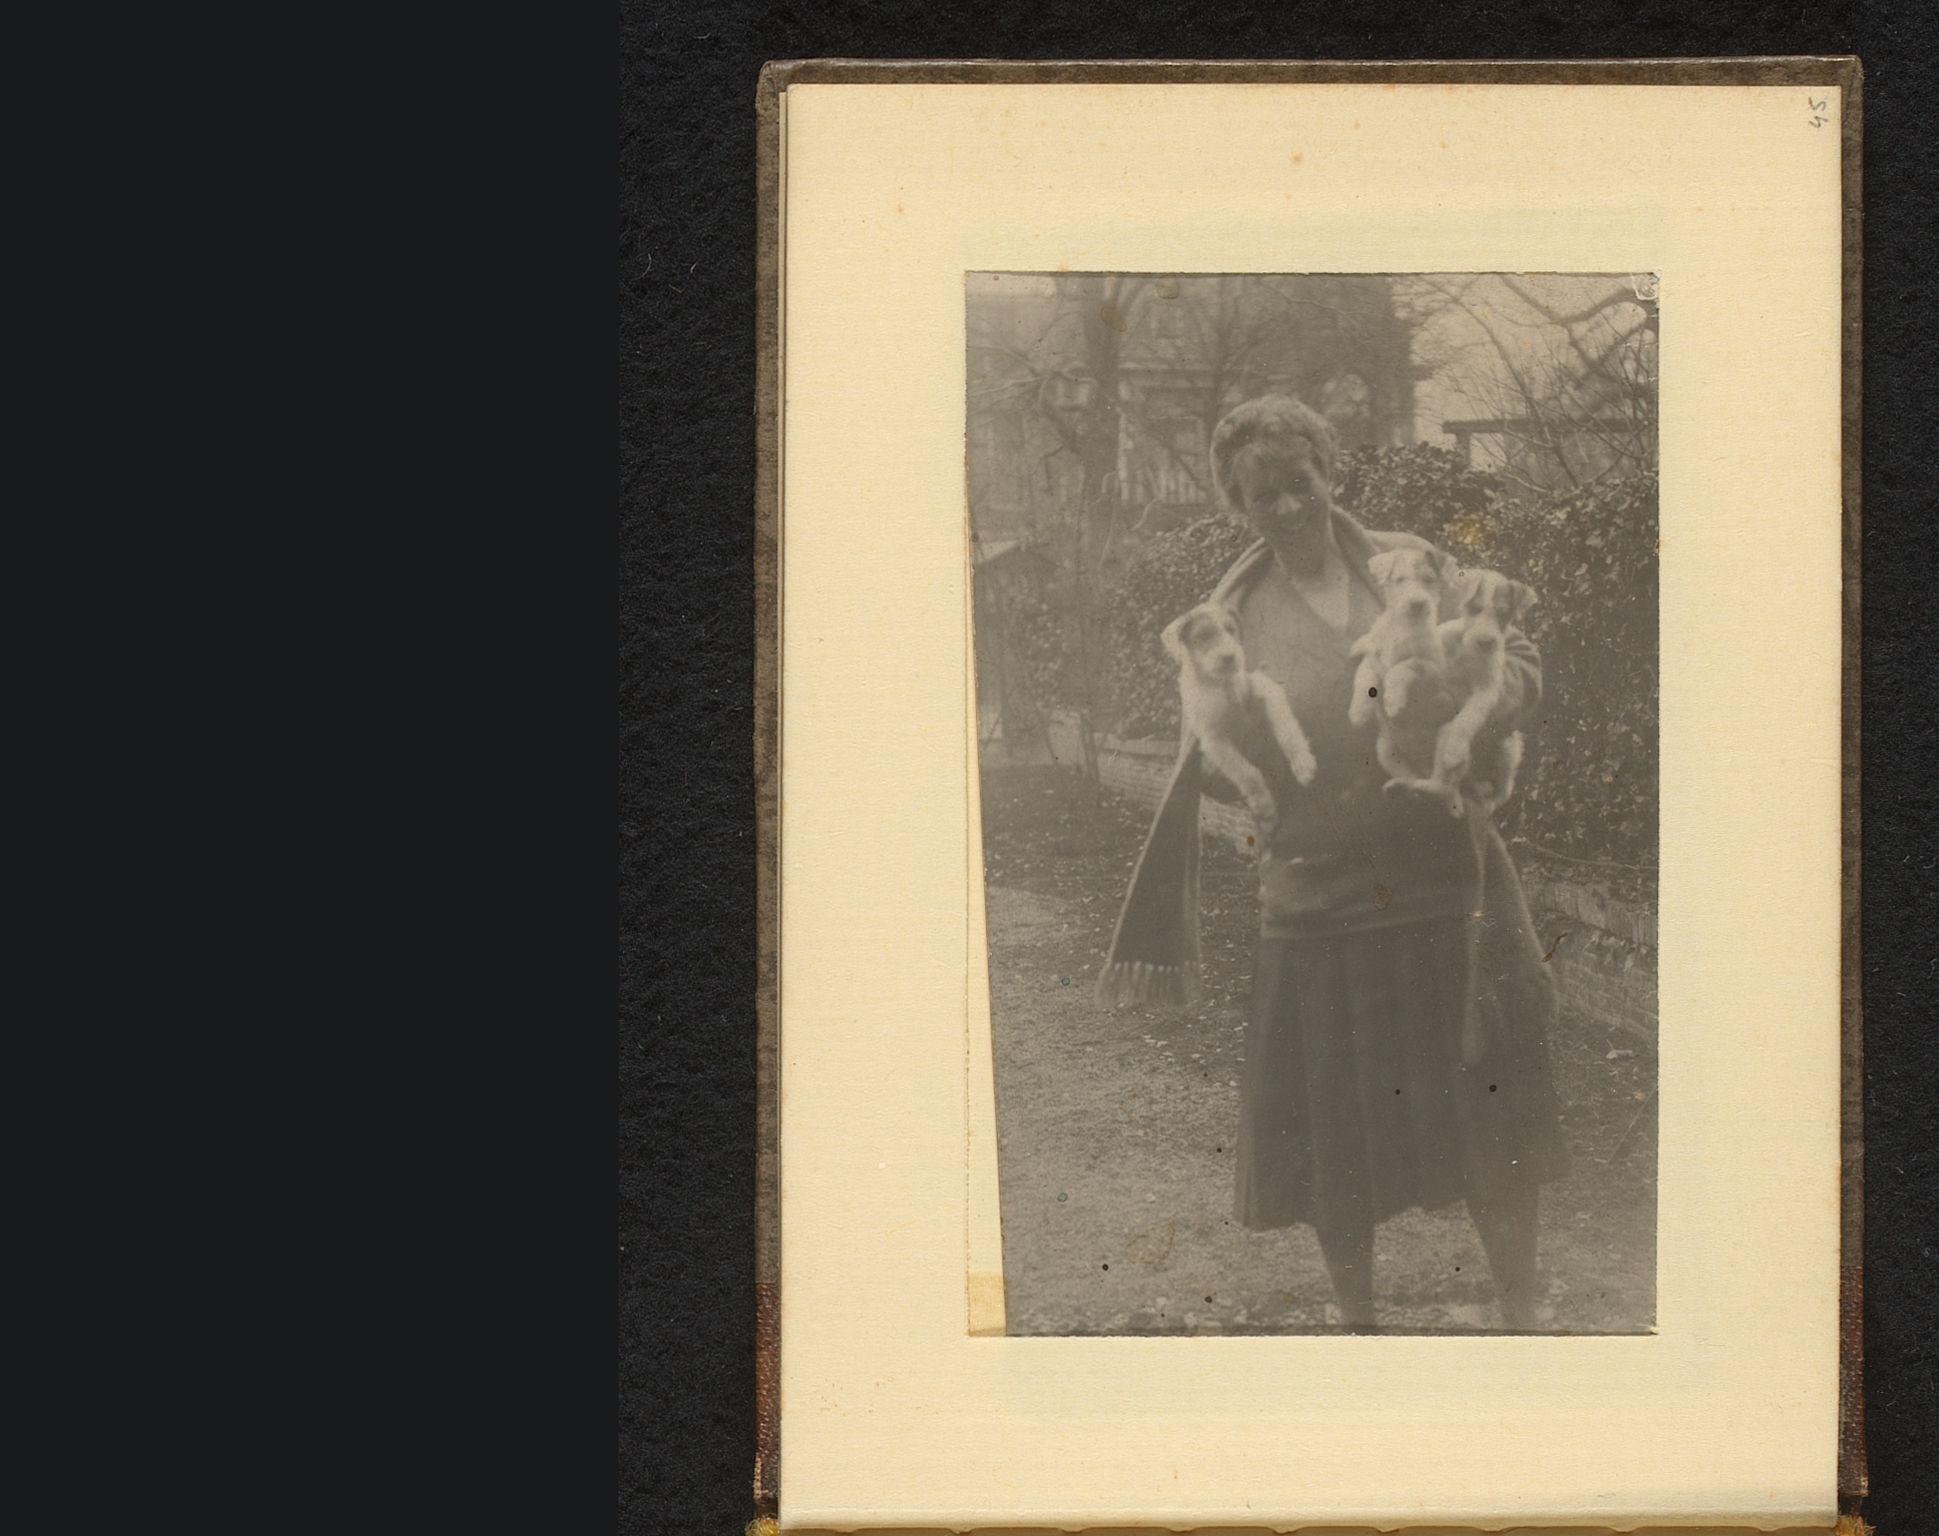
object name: photograph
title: Vrouw met drie honden in haar armen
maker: norbert van den berg (1901-1972)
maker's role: amateurfotograaf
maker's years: 1901-1972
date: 1935-1950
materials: paper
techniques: gelatin silver print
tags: adult woman, dog